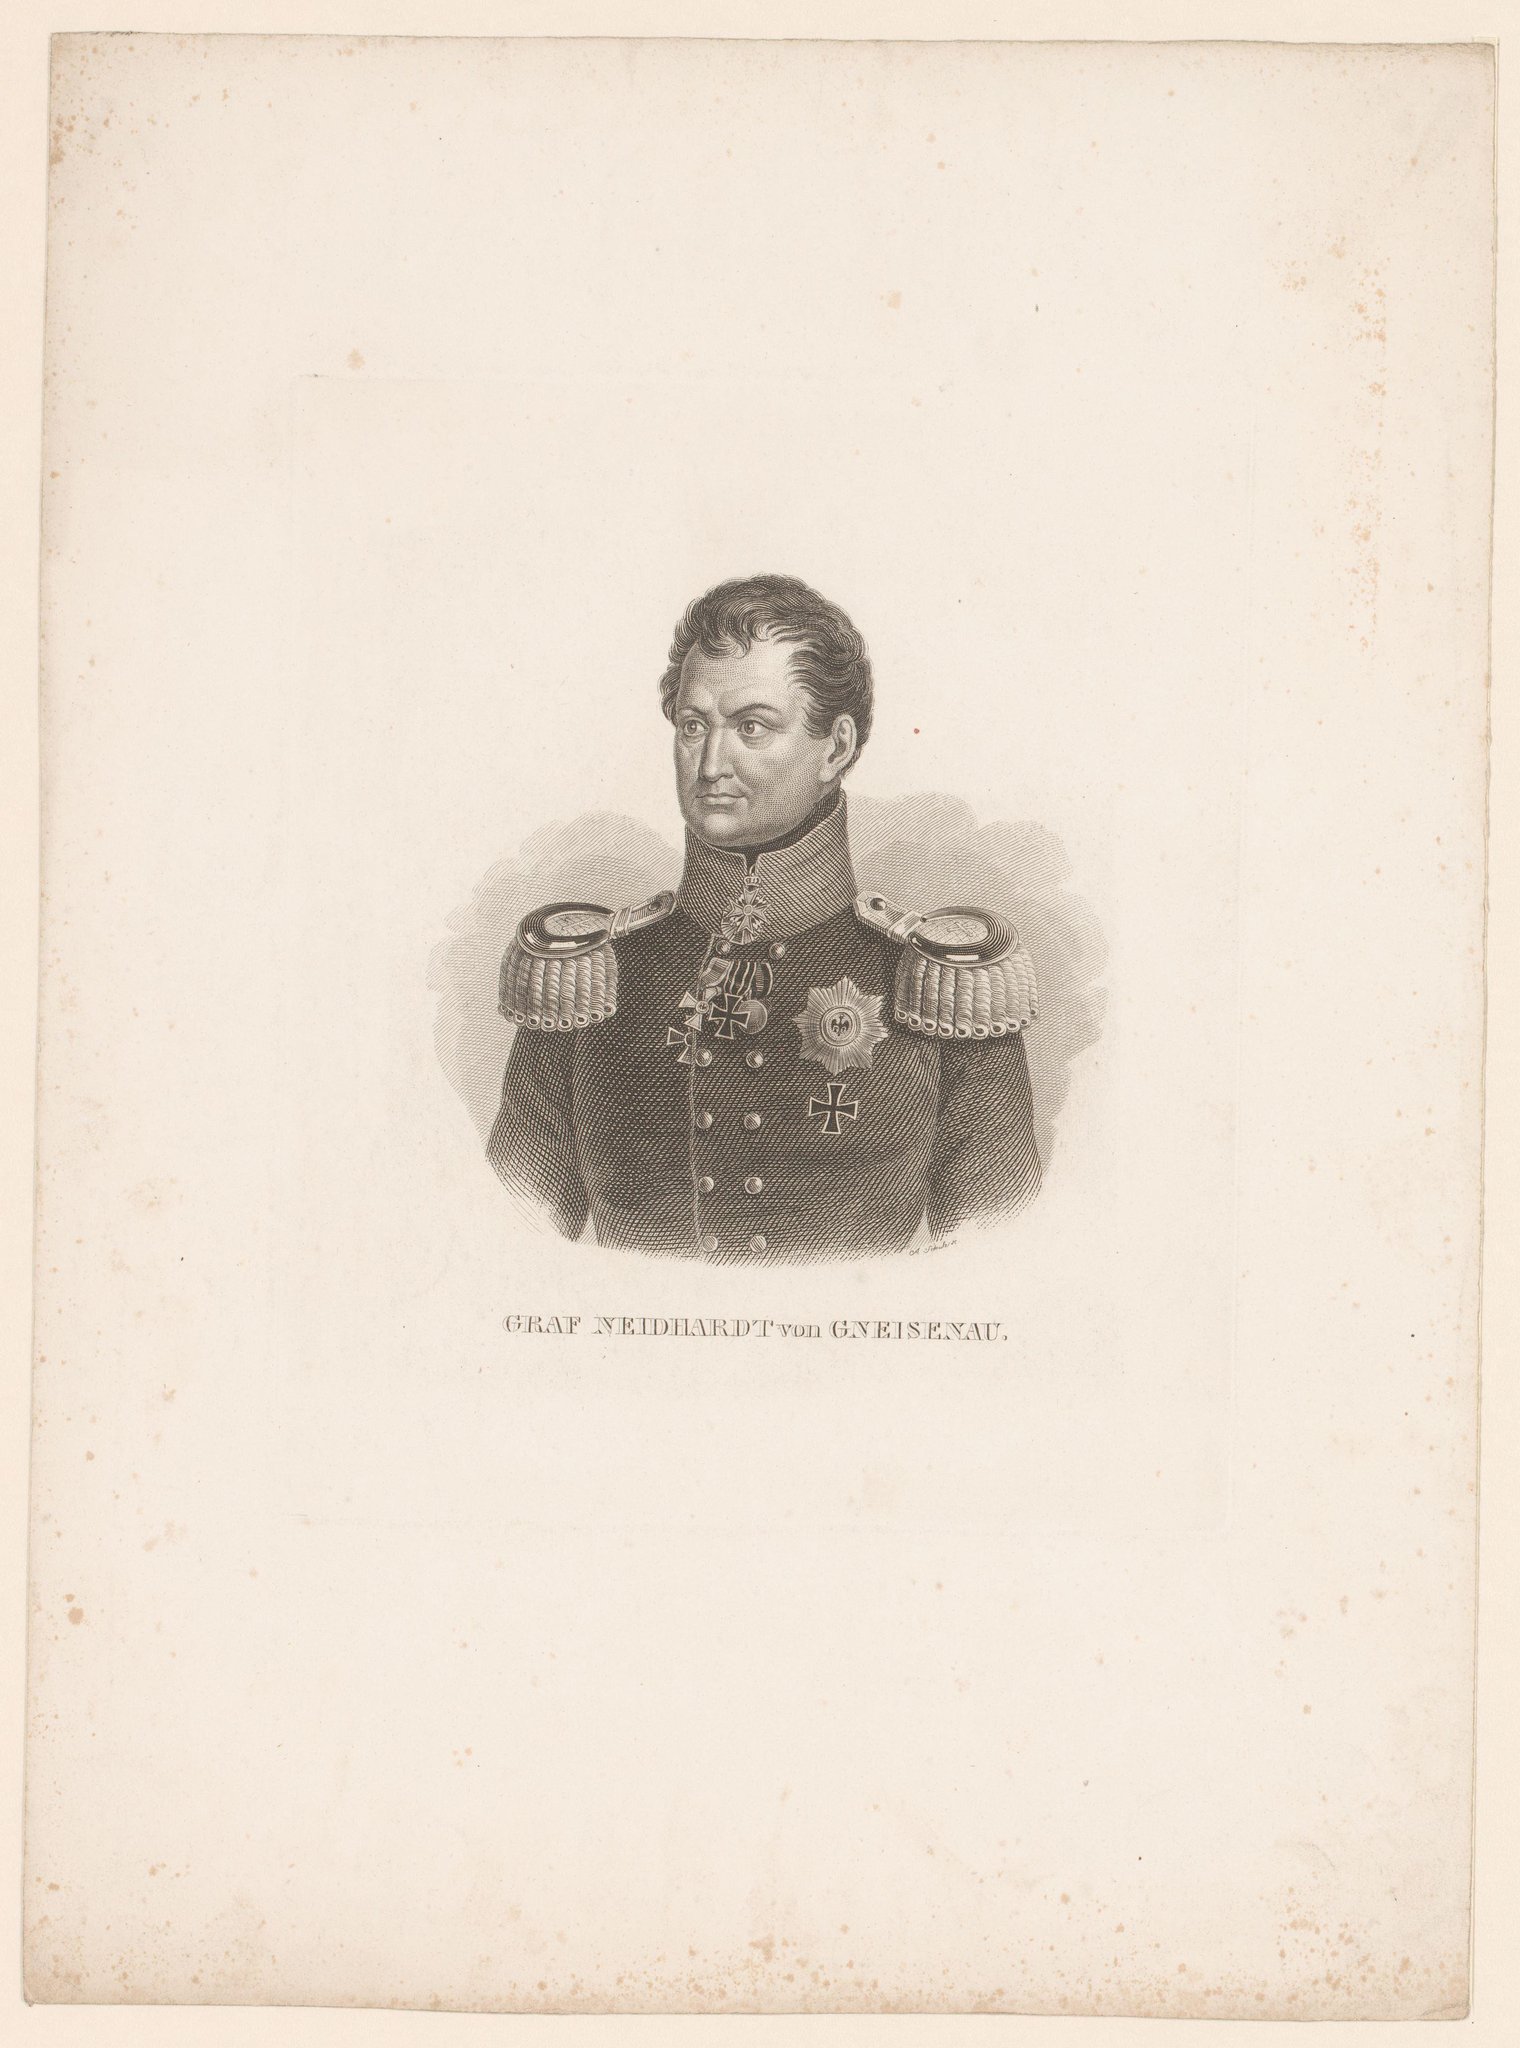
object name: print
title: Portret van August Wilhelm Antonius Neidhardt, graaf von Gneisenau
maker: albert schule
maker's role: painter, print maker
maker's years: 1801-1875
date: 1811-1875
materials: paper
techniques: engraving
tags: knighthood order (with name) - insignia of a knighthood order, e.g.: badge, chain (with name of order), historical persons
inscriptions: collector's mark: Lugt 2228